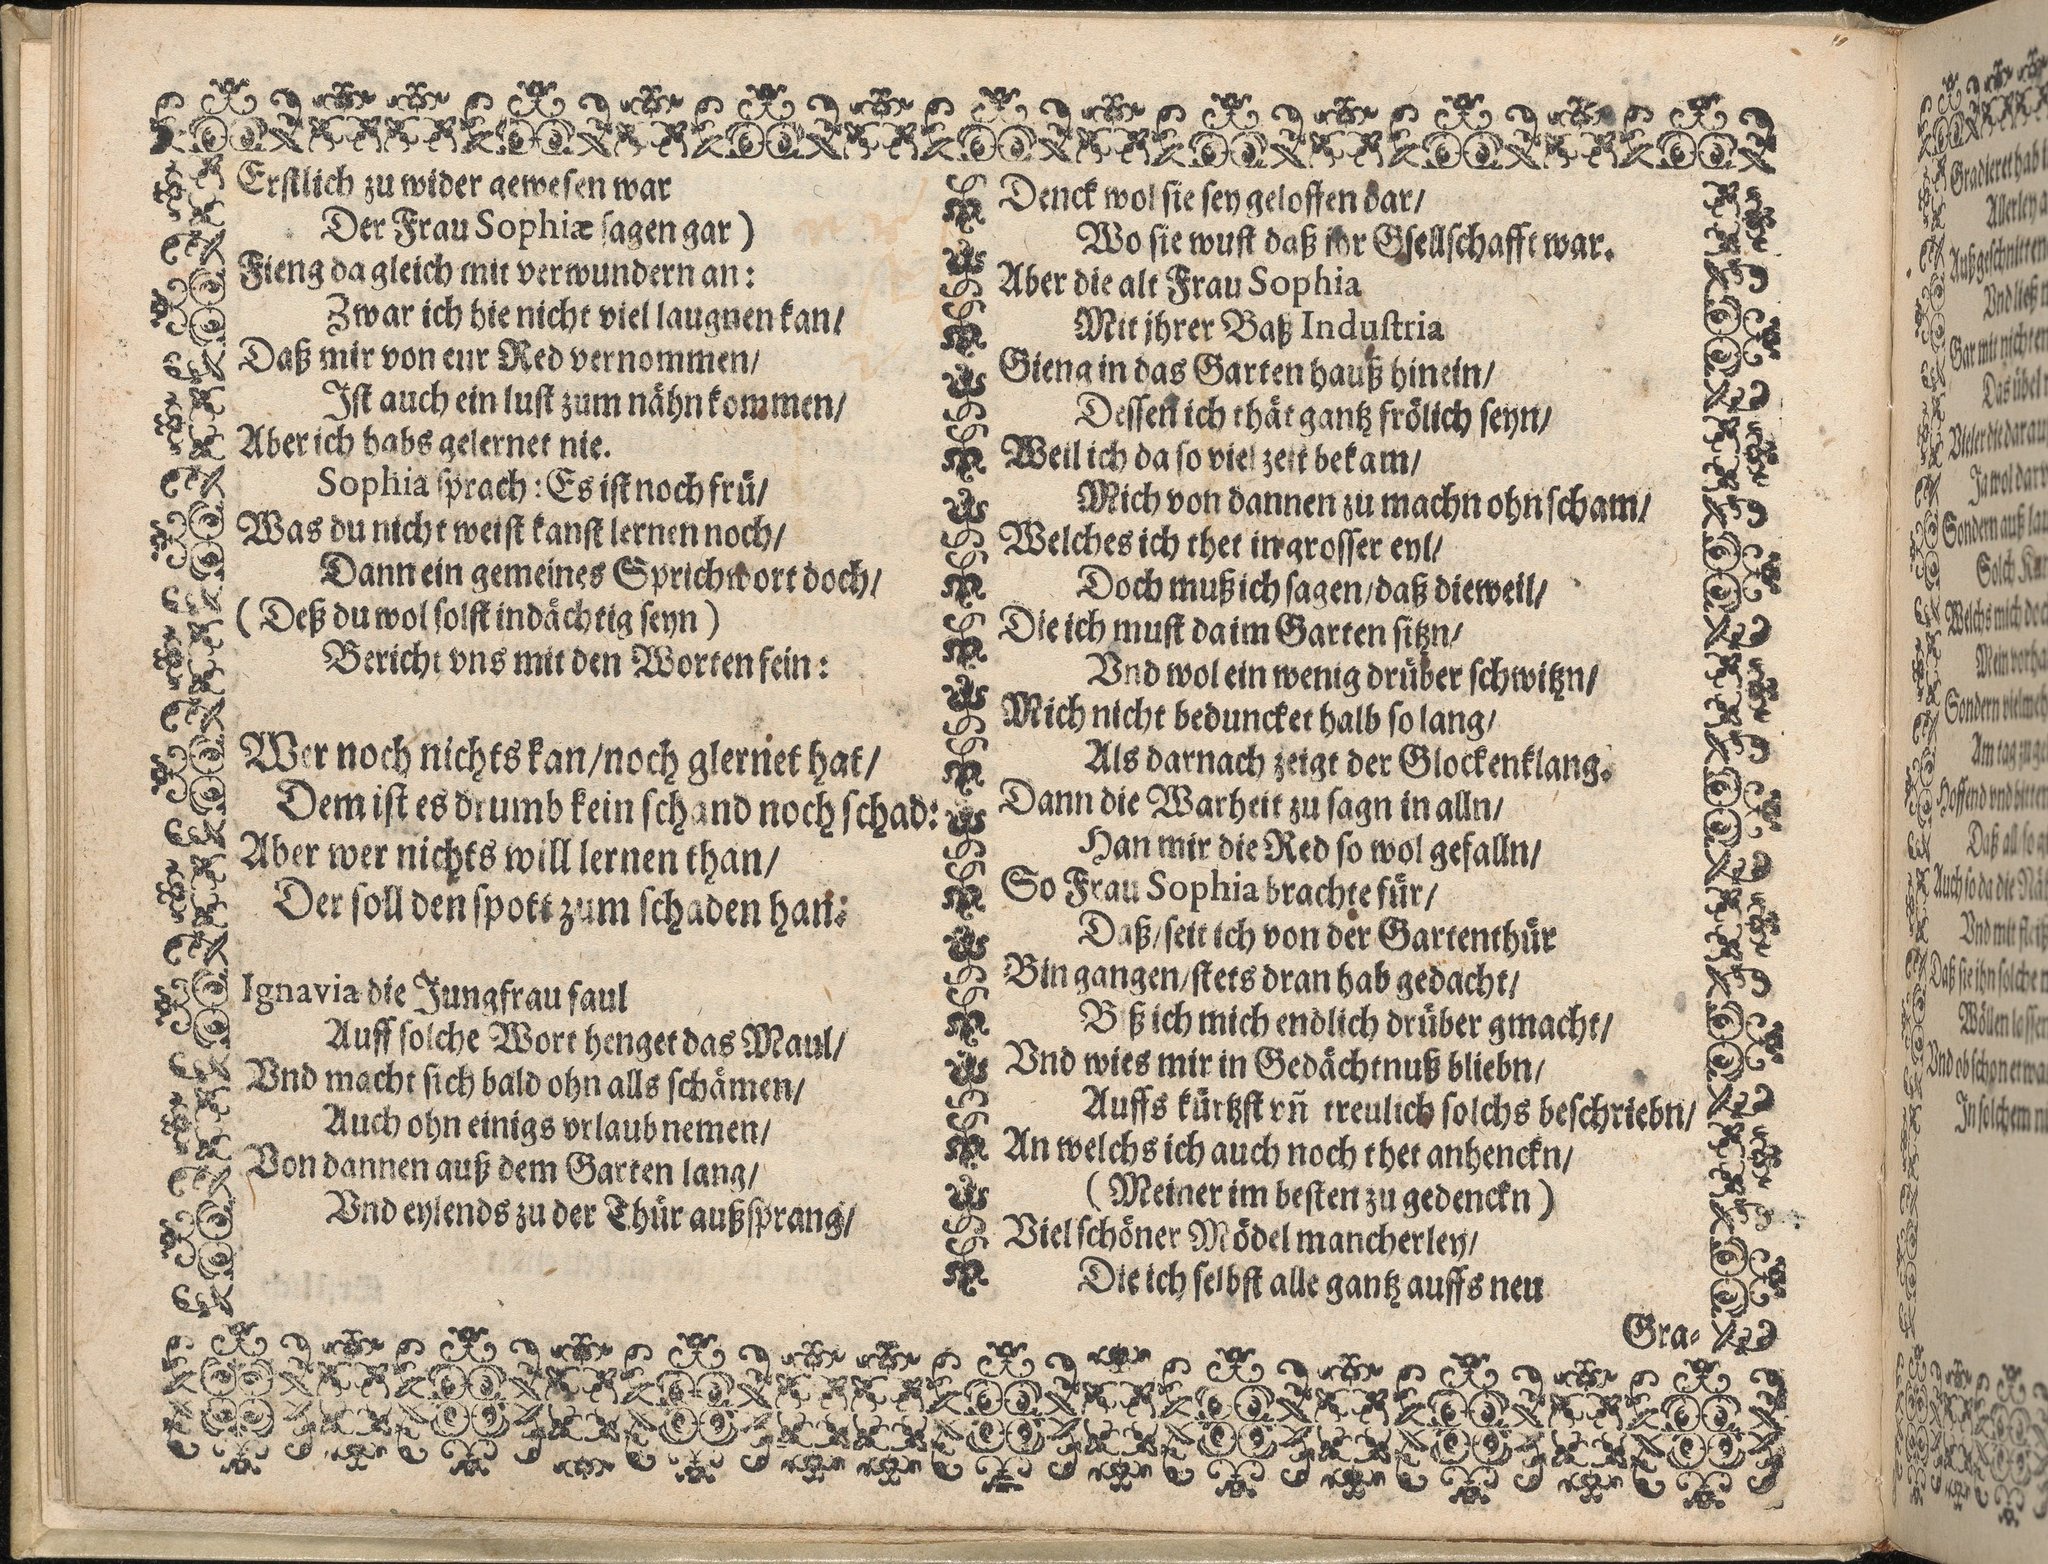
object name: book print ornament architecture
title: Newes Modelbuch in Kupffer (Page 7r)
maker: johann sibmacher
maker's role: artist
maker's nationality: german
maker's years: 1590-1611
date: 1604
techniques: woodcut